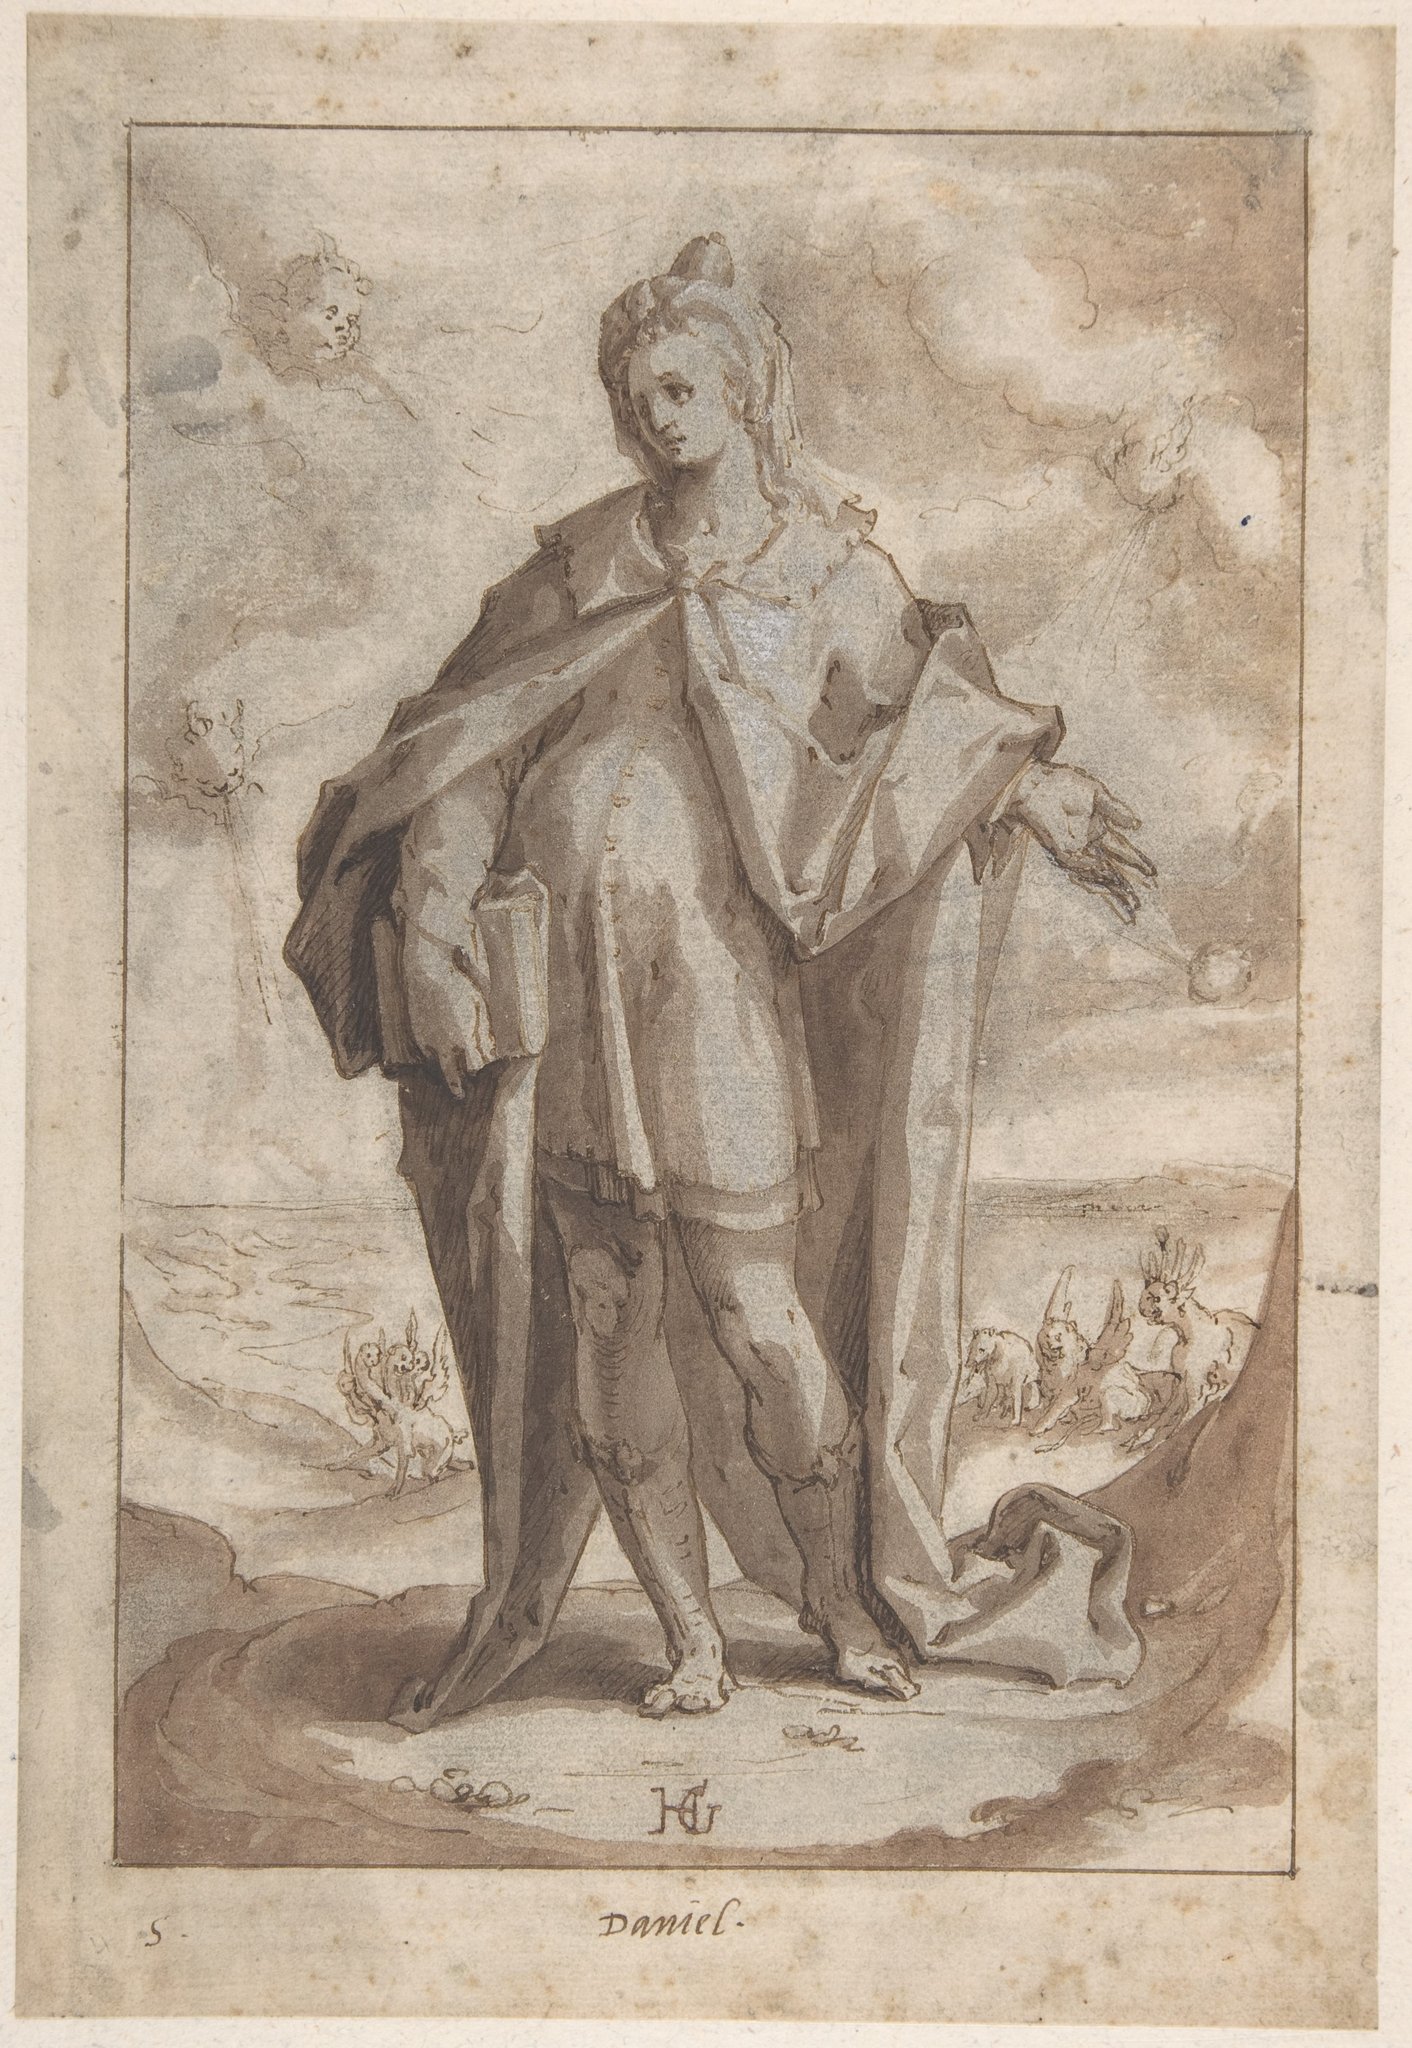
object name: drawing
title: The Prophet Daniel in a Landscape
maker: hendrick goltzius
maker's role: artist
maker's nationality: netherlandish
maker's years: 1558-1617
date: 1567-1633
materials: chalk, ink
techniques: brush, heightening, incising, pen, wash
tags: men